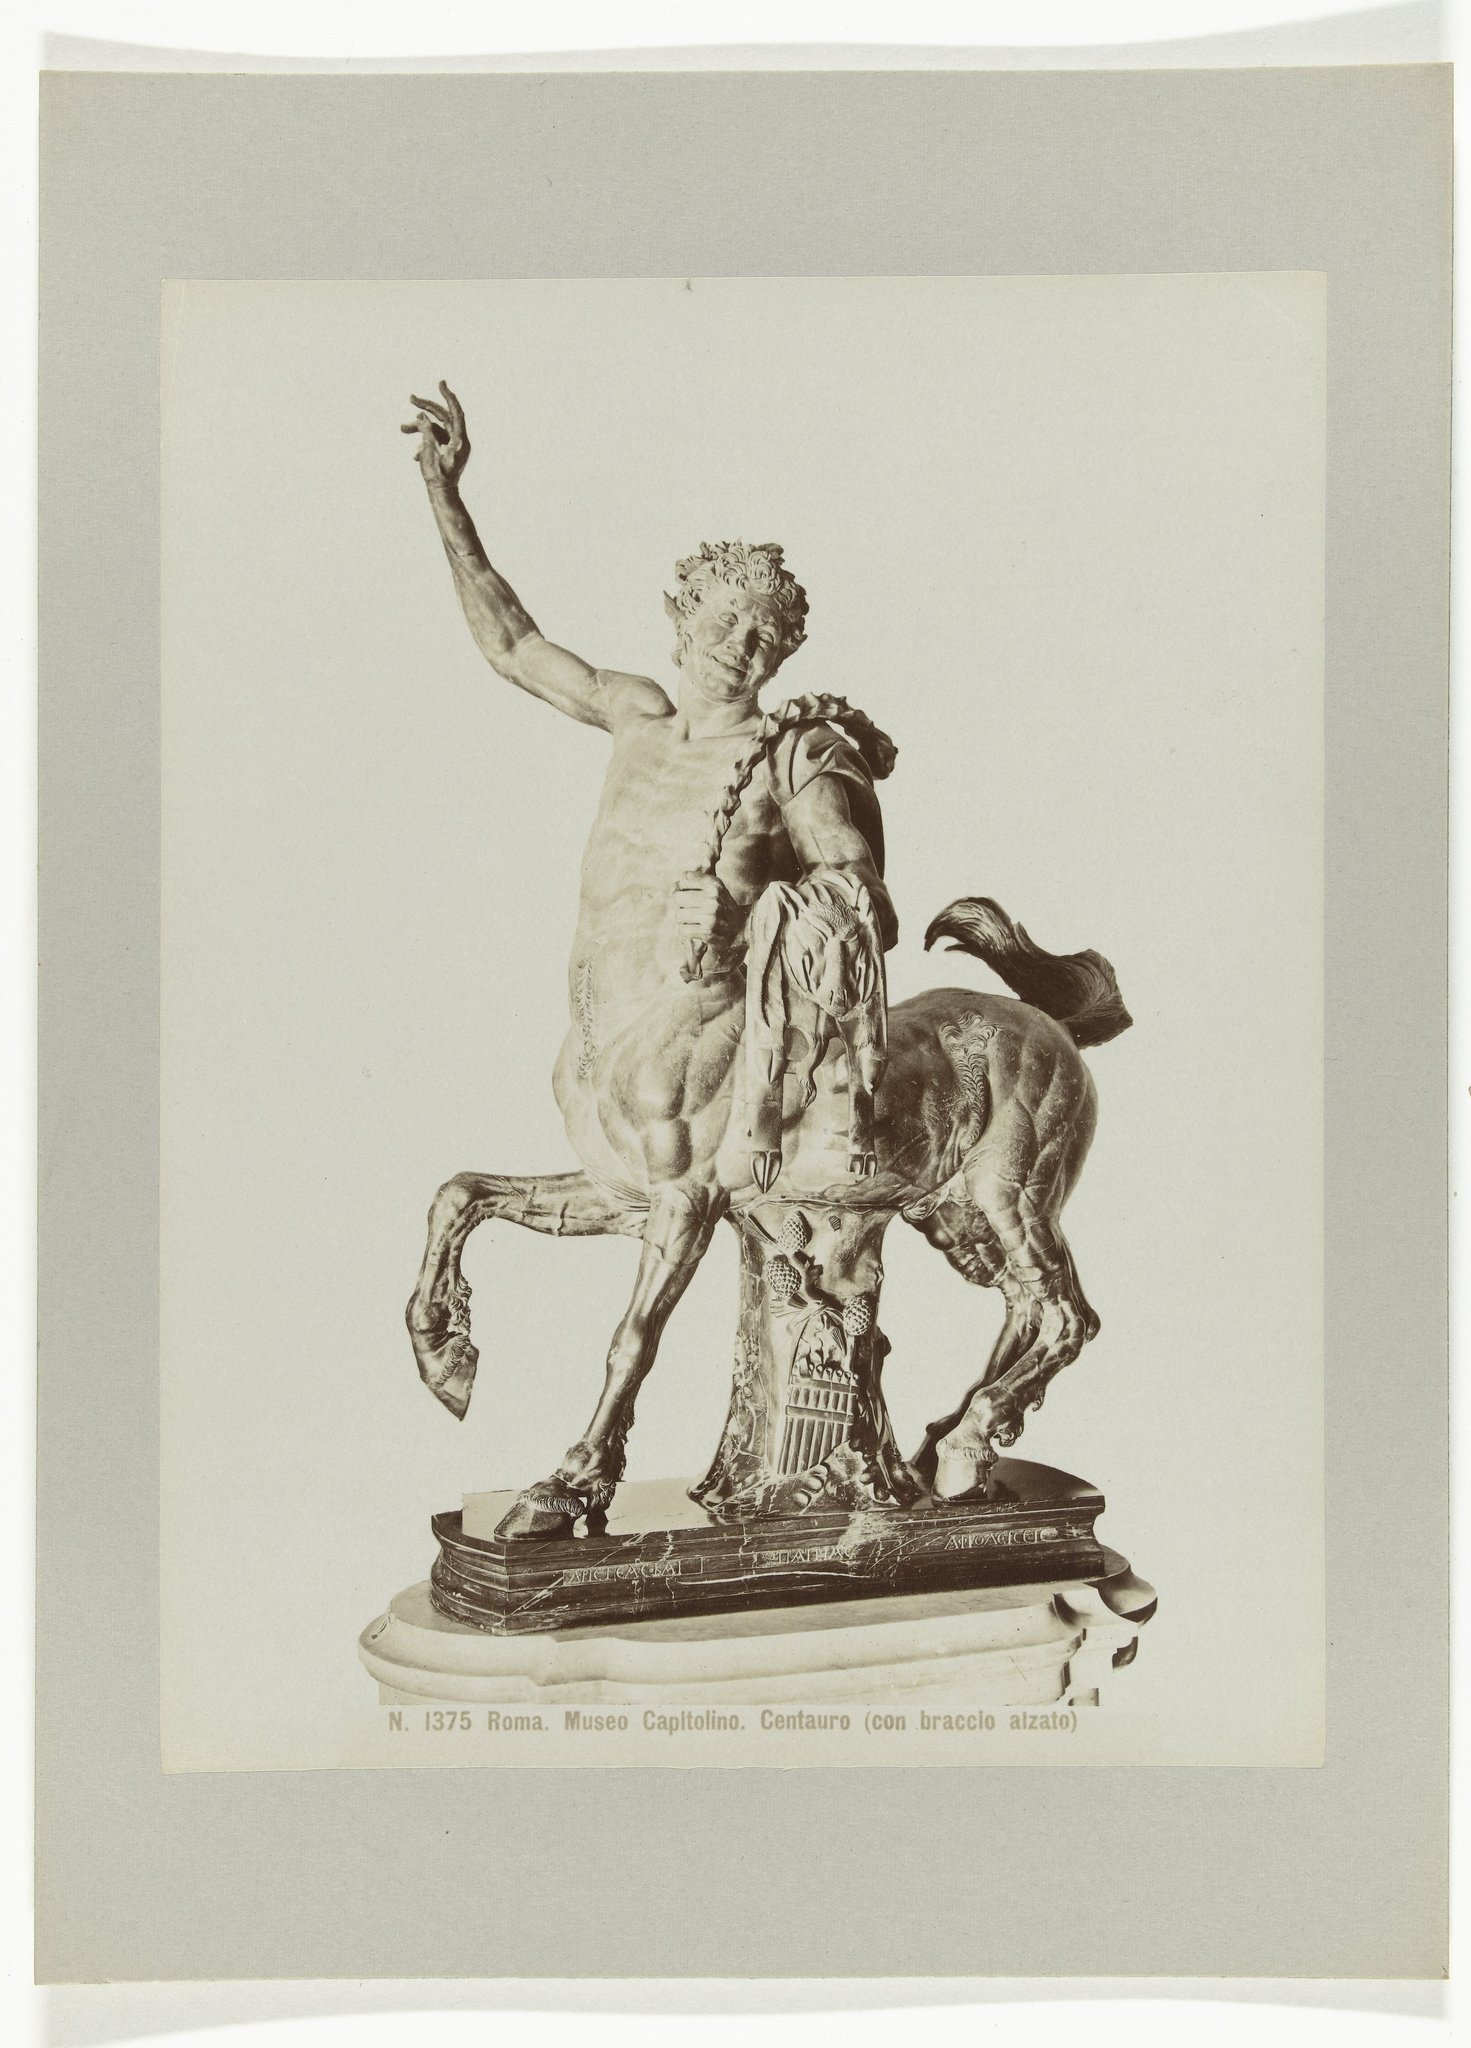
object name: photograph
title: N. 1375 Roma. Museo Capitolino. Centauro (con braccio alzato)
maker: Anonymous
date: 1880-1904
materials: cardboard, paper, photographic support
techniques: albumen print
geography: rome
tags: capitolijnse musea